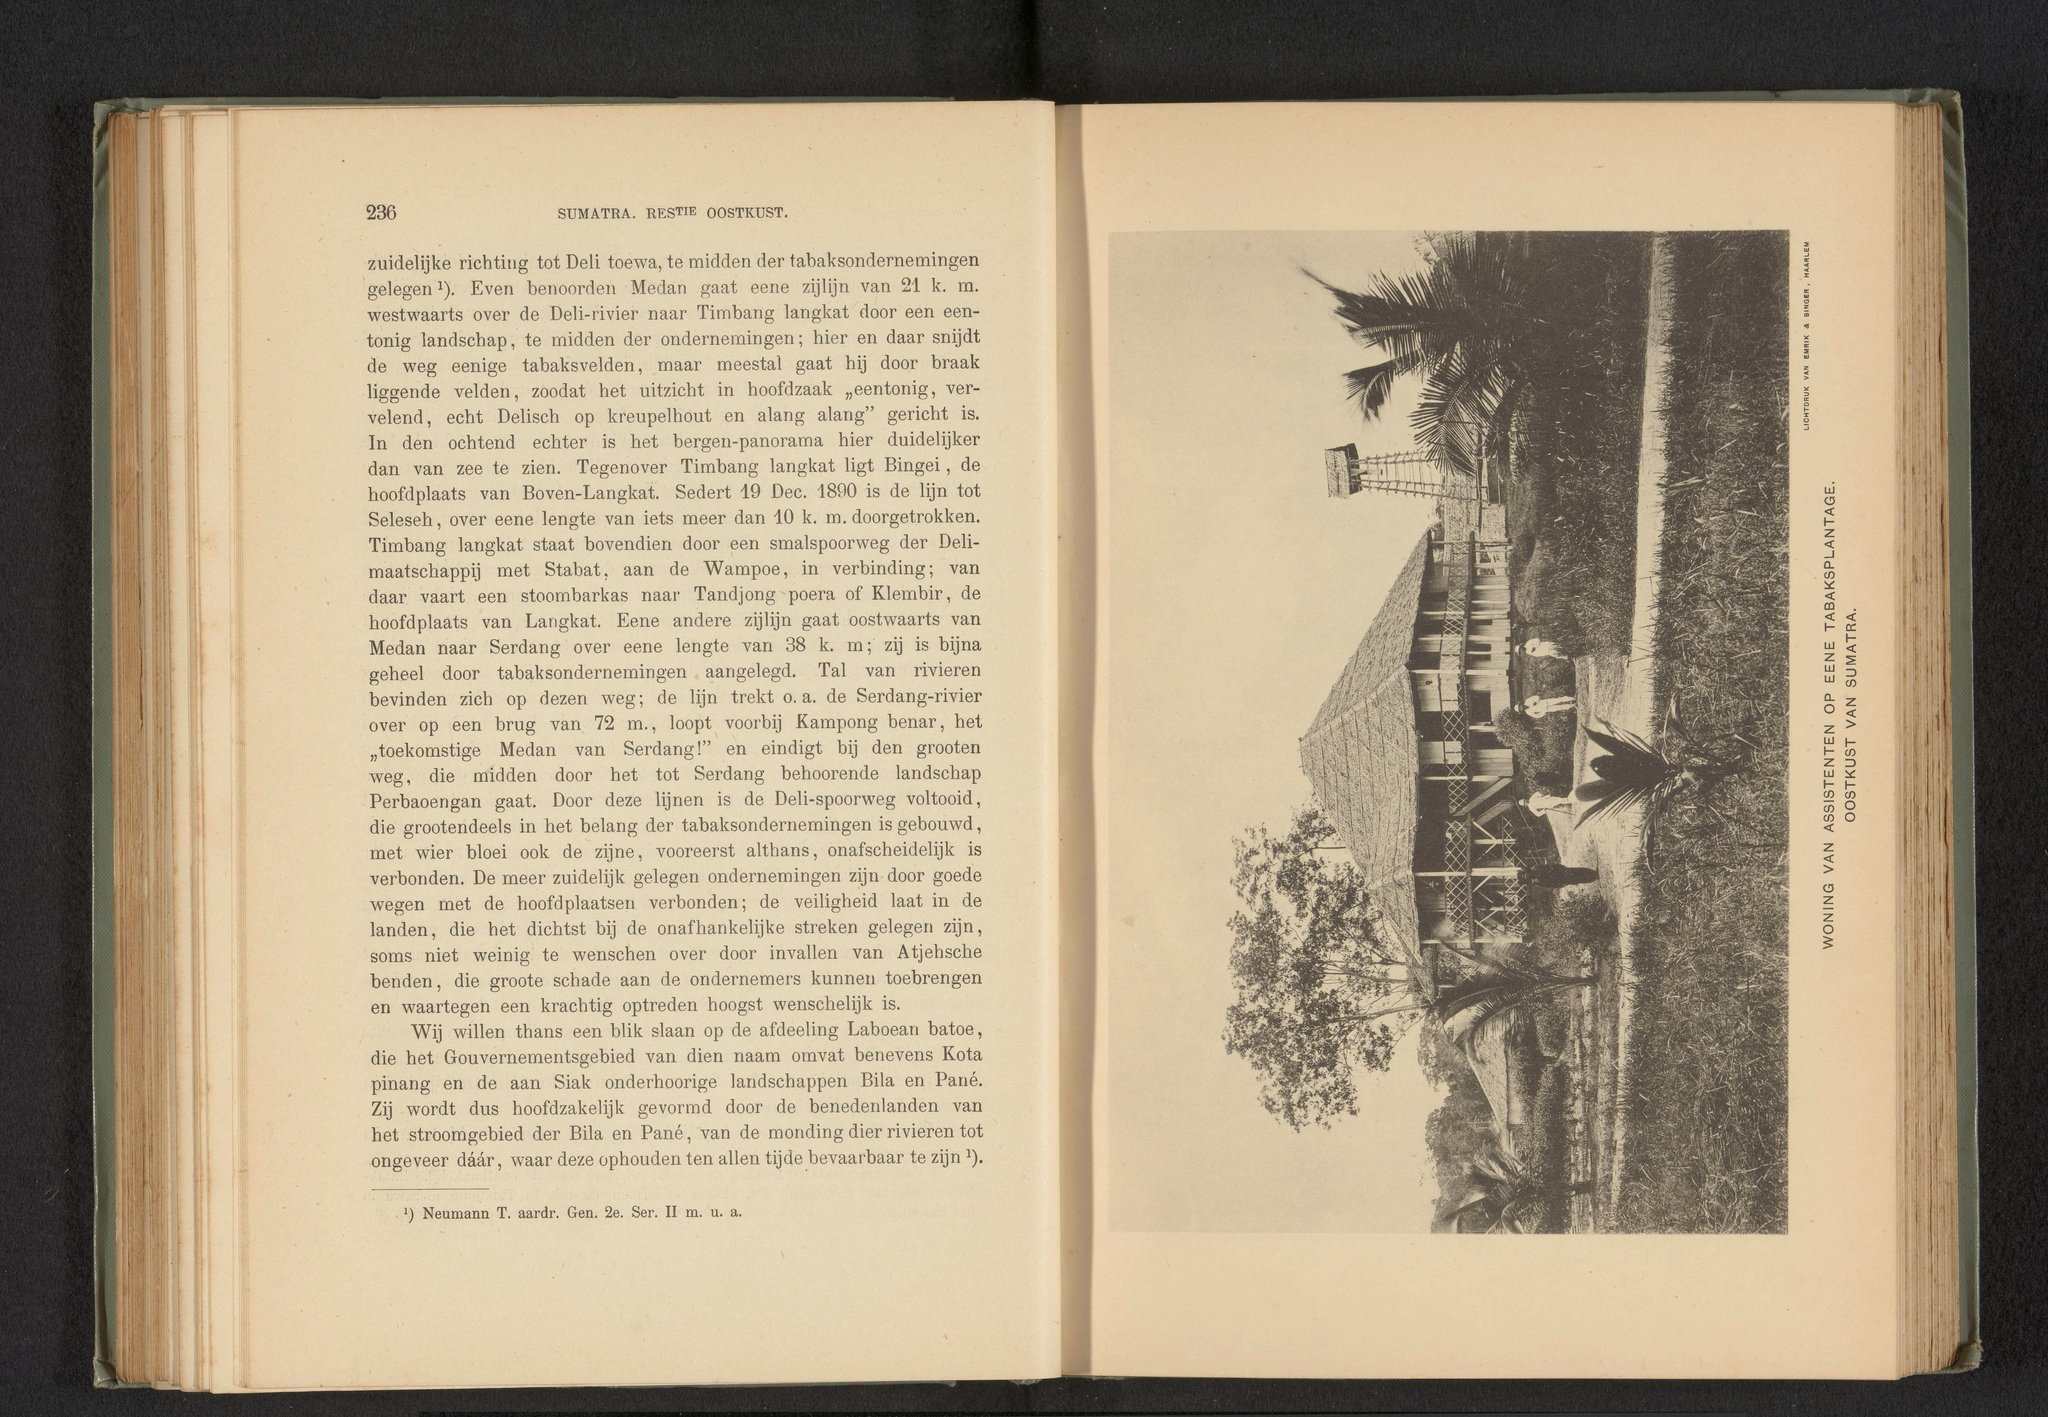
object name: page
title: Gezicht op een huis van medewerkers van een tabaksplantage op Sumatra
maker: Anonymous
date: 1883-1894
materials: paper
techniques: photograph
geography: haarlem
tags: housing, sumatra